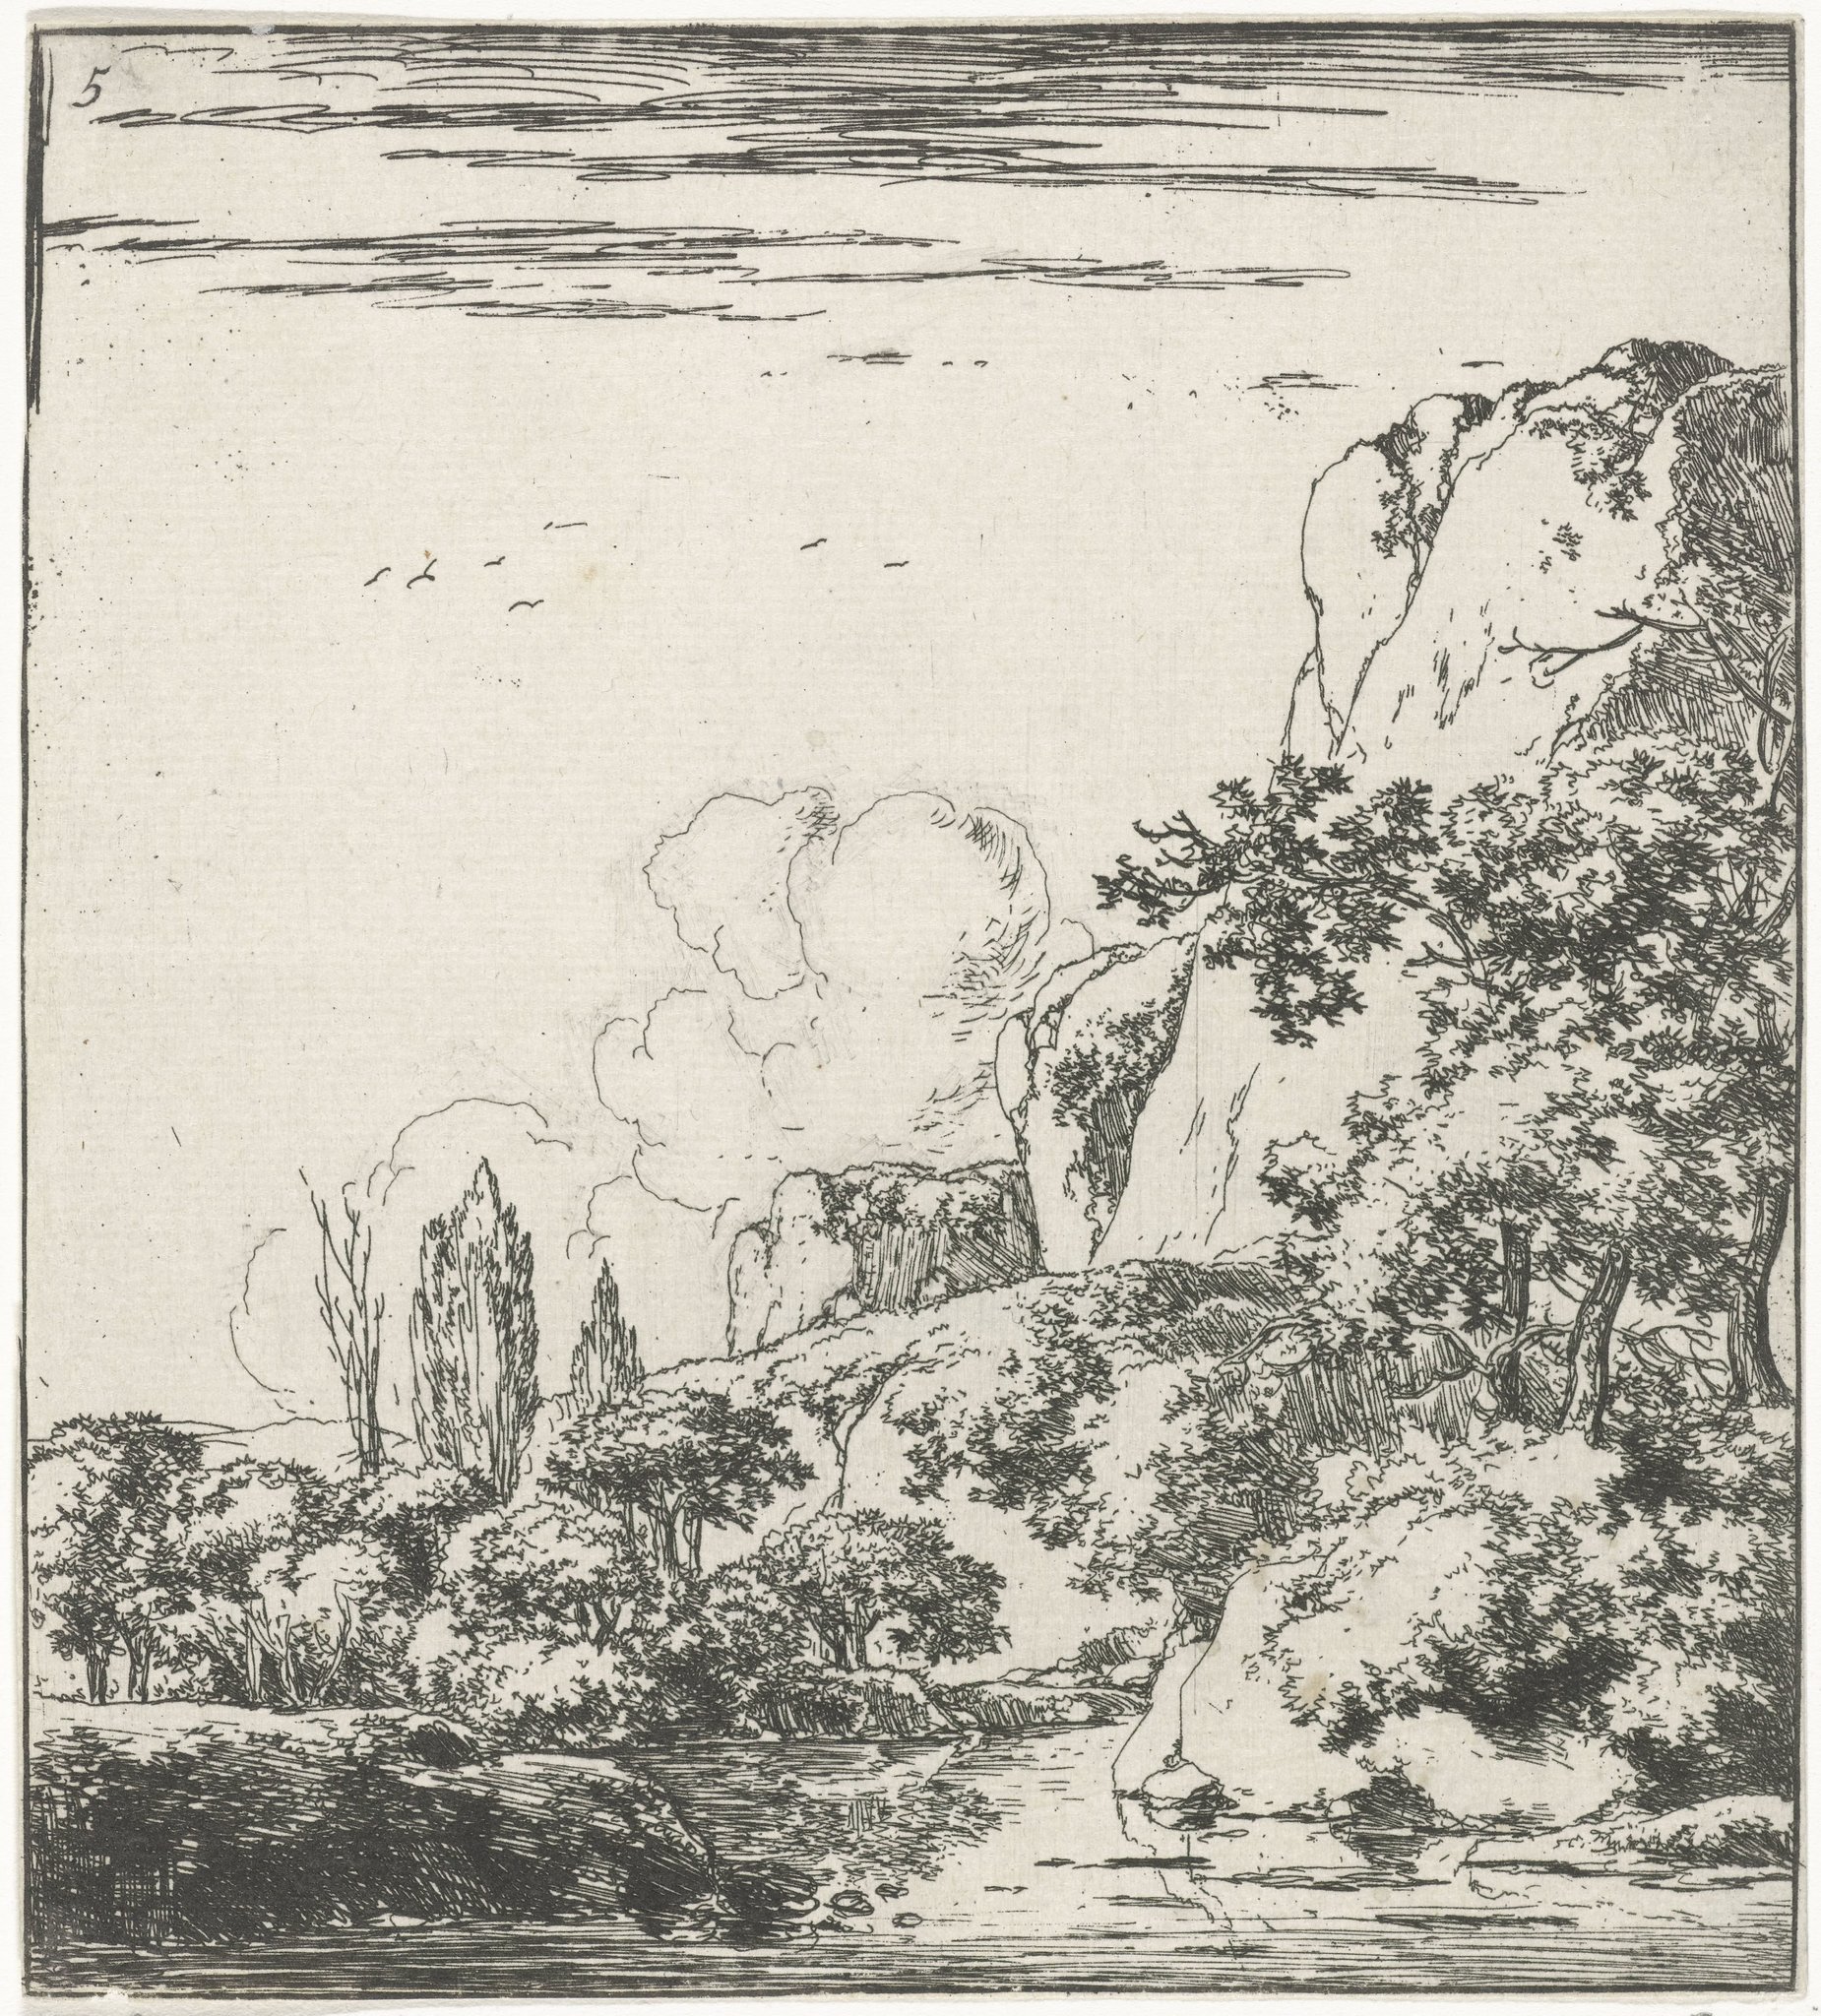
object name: print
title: Rivier tussen de rotsen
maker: herman naiwincx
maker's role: draughtsman, print maker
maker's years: 1623-1670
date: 1633-1670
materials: paper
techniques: etching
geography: amsterdam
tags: trees, river, rock-formations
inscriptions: collector's mark: Lugt 240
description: Een rivier tussen de rotsen. Op de linker en rechteroever verschillende soorten bomen.